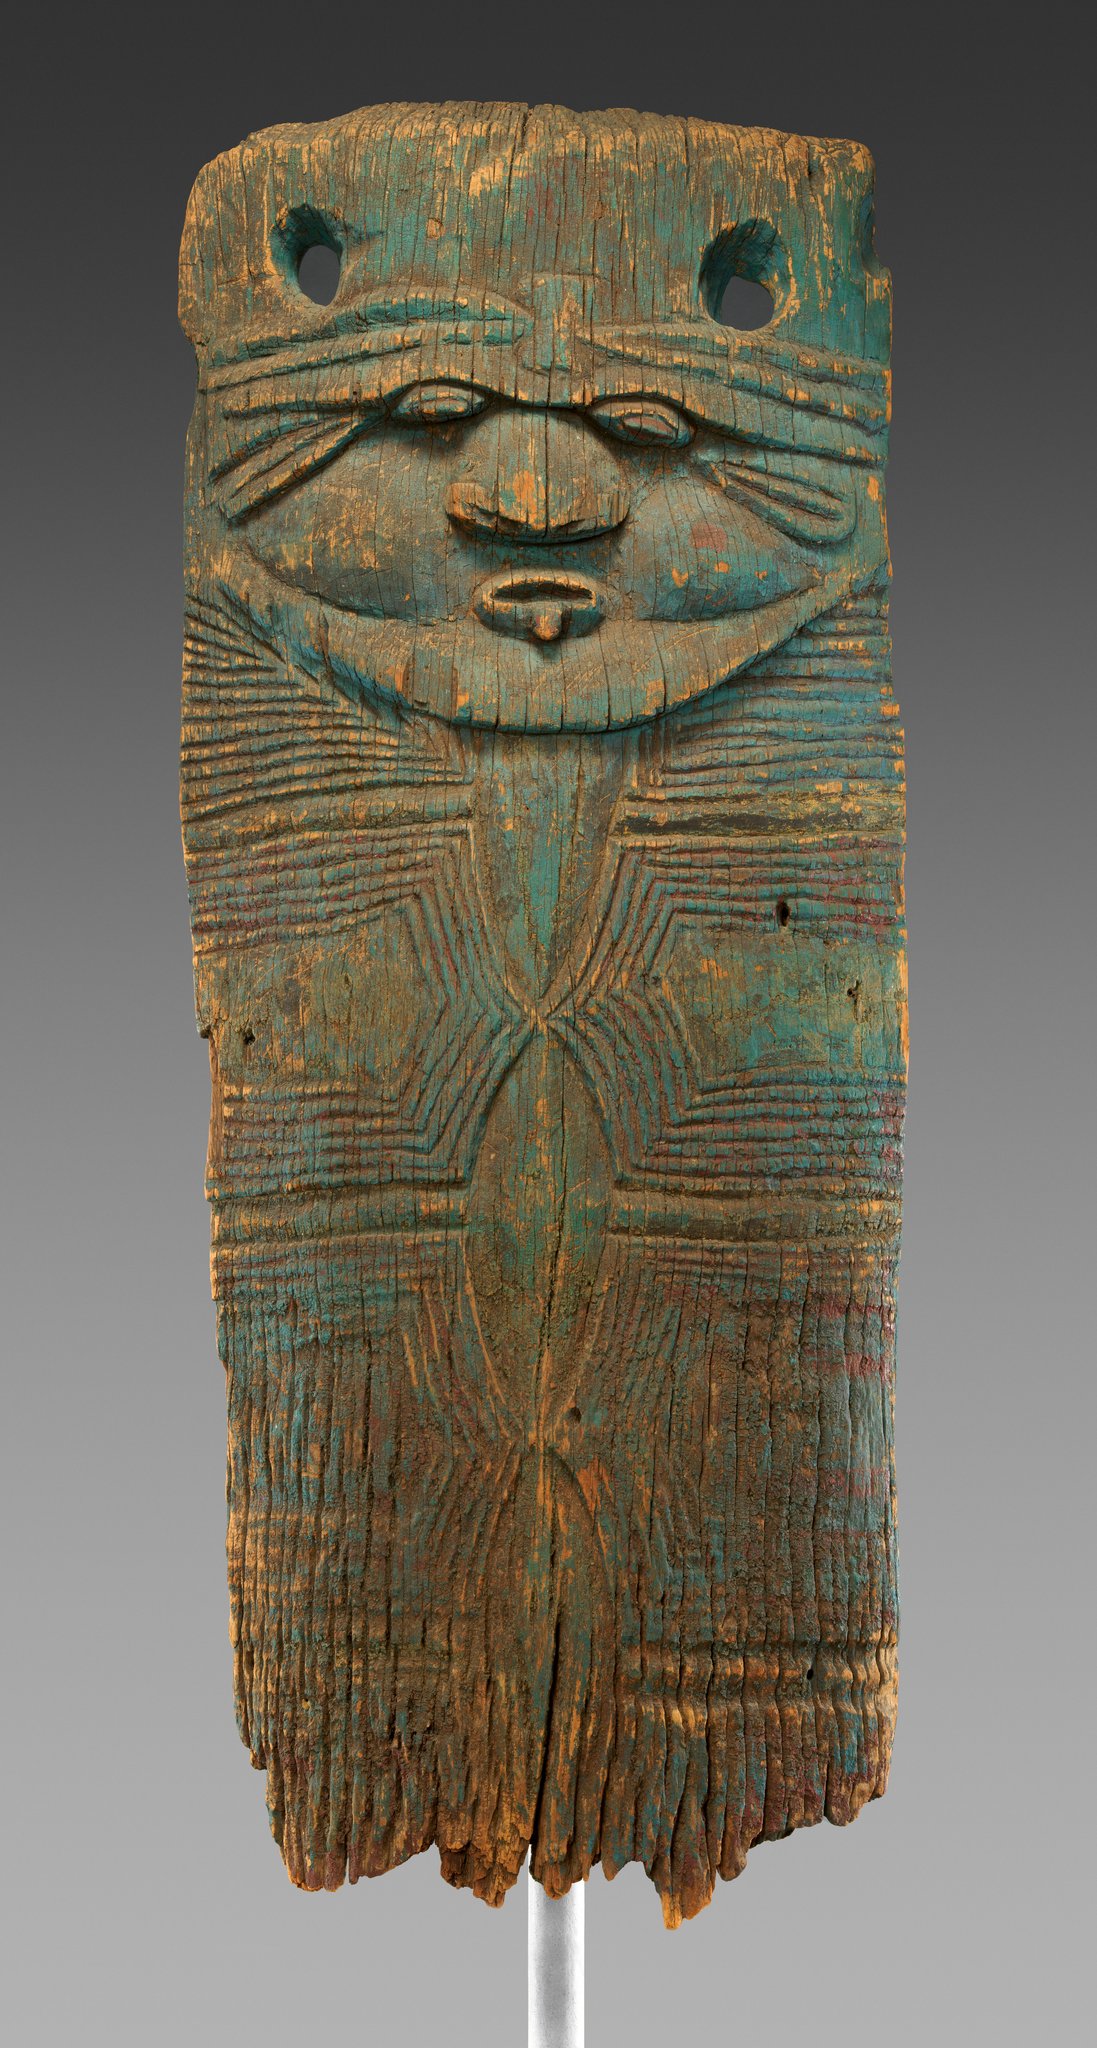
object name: door board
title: Door board (jovo)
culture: kanak people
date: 1801-1900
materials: pigment, wood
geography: new caledonia